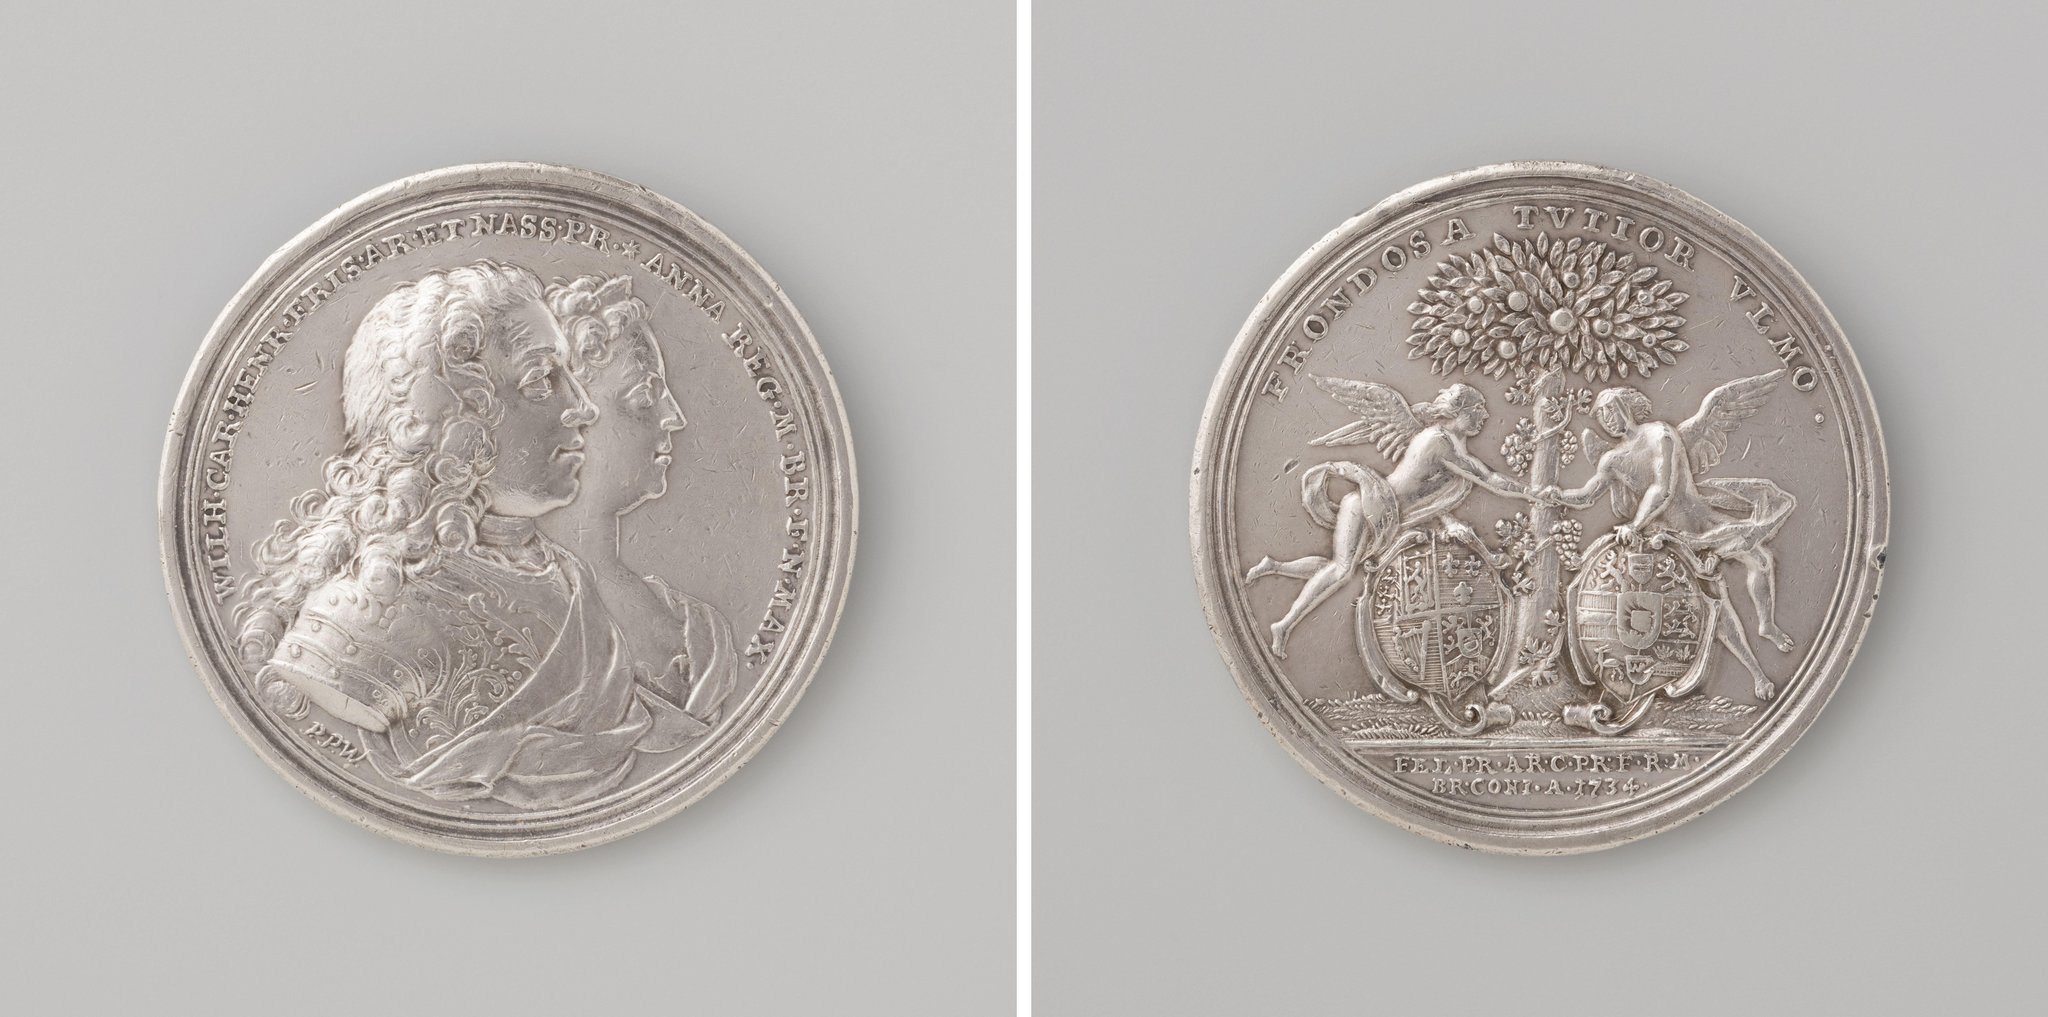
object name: history medal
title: Huwelijk van Willem IV met prinses Anna van Engeland te Londen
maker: peter paul werner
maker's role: medailleur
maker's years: 1689-1771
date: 1734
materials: silver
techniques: striking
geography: nuremberg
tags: willem iv (prins van oranje-nassau), the hague, anna van hannover, london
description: Zilveren penning. Voorzijde: borststuk man en vrouw binnen omschrift. Keerzijde: twee gevleugelde genii, elk met een hand rustend op wapenschild reiken elkaar de hand onder een met wijnranken en druiventrossen omslingerde oranjeboom binnen omschrift; afsnede: opschrift